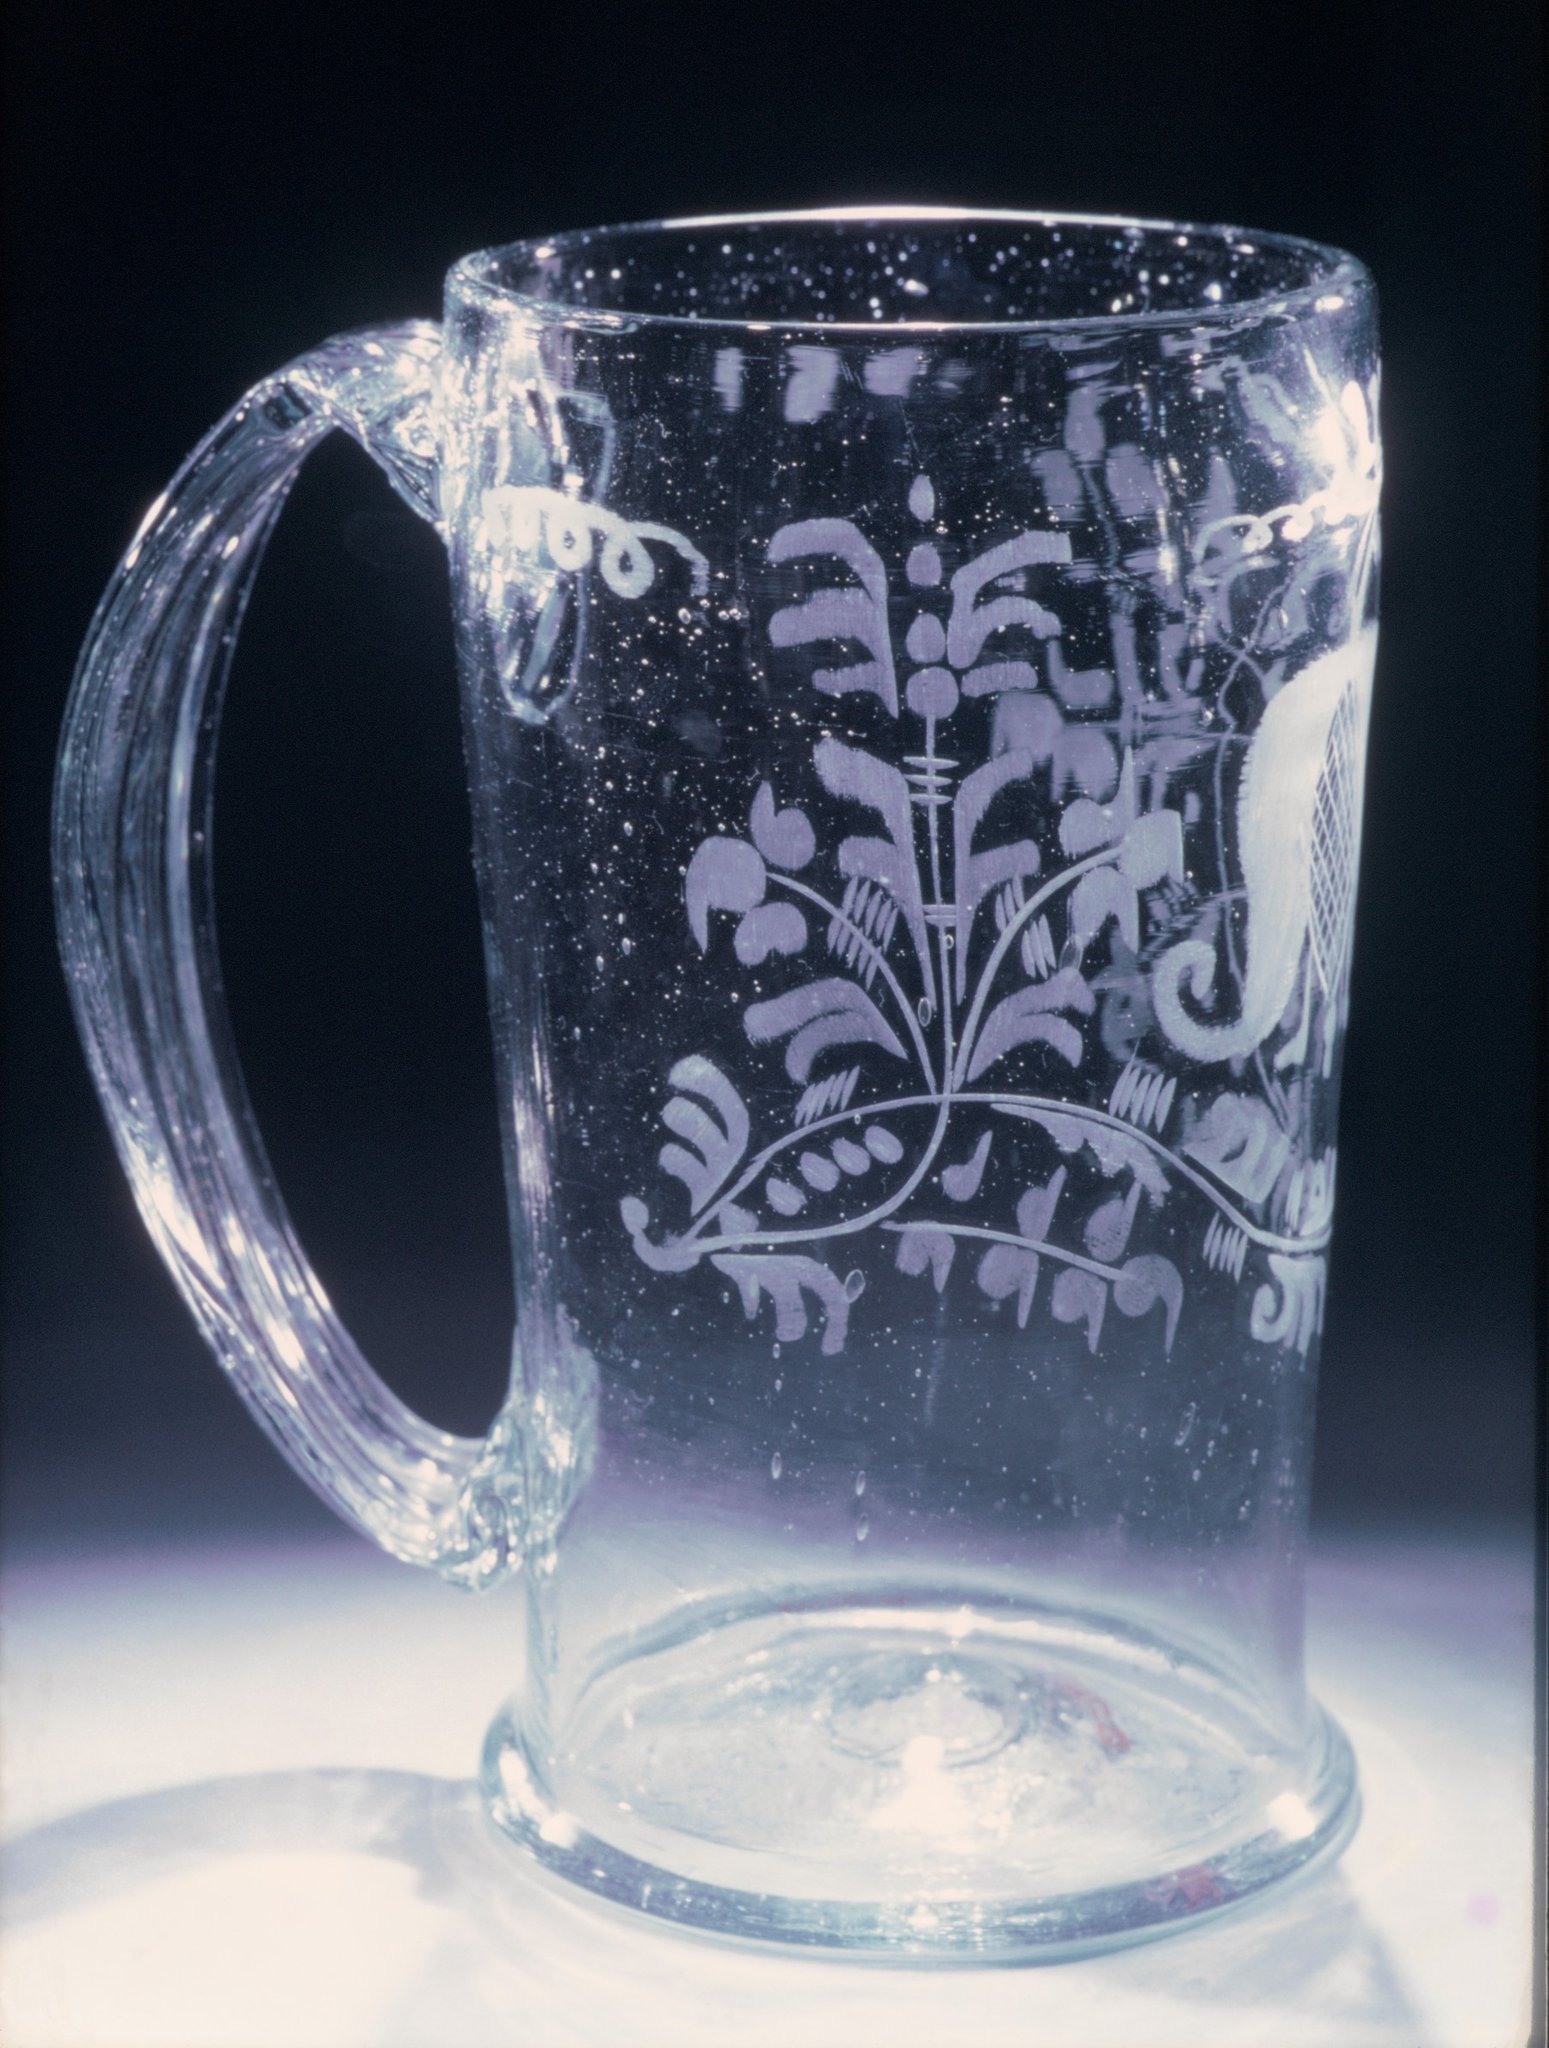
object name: mug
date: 1770-1820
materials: glass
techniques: engraving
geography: czech republic